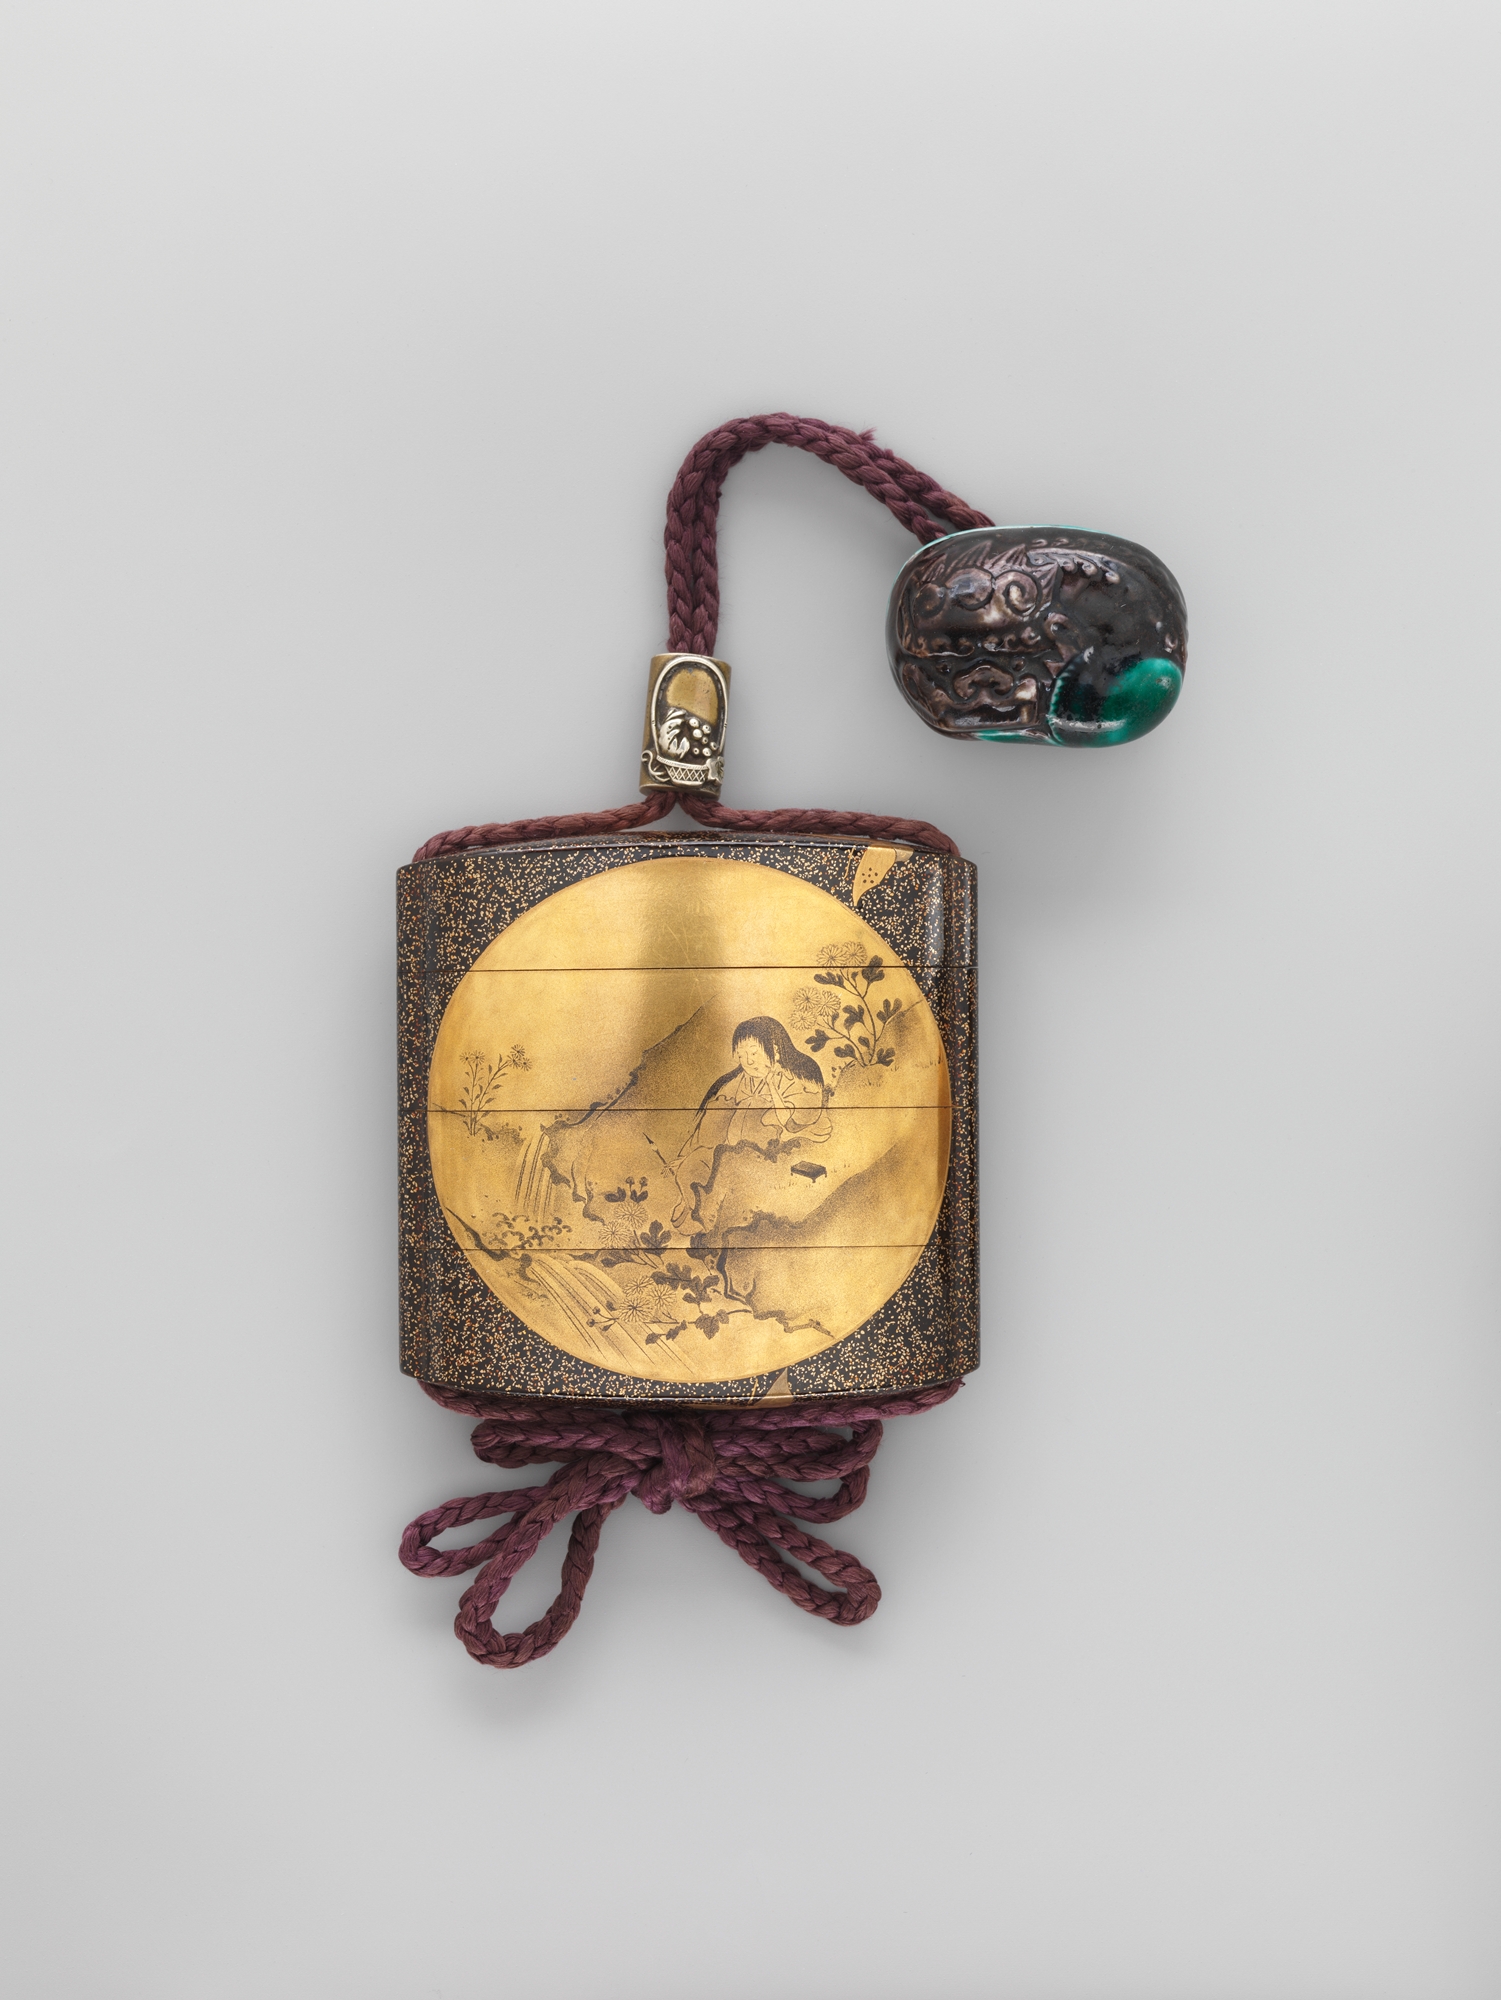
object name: inrō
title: Inrō with “Chrysanthemum Youth” (Kikujidō)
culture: japanese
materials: ceramic, gold, ink, lacquer, metal, wood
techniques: inlay, lacquer, painting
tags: human figures